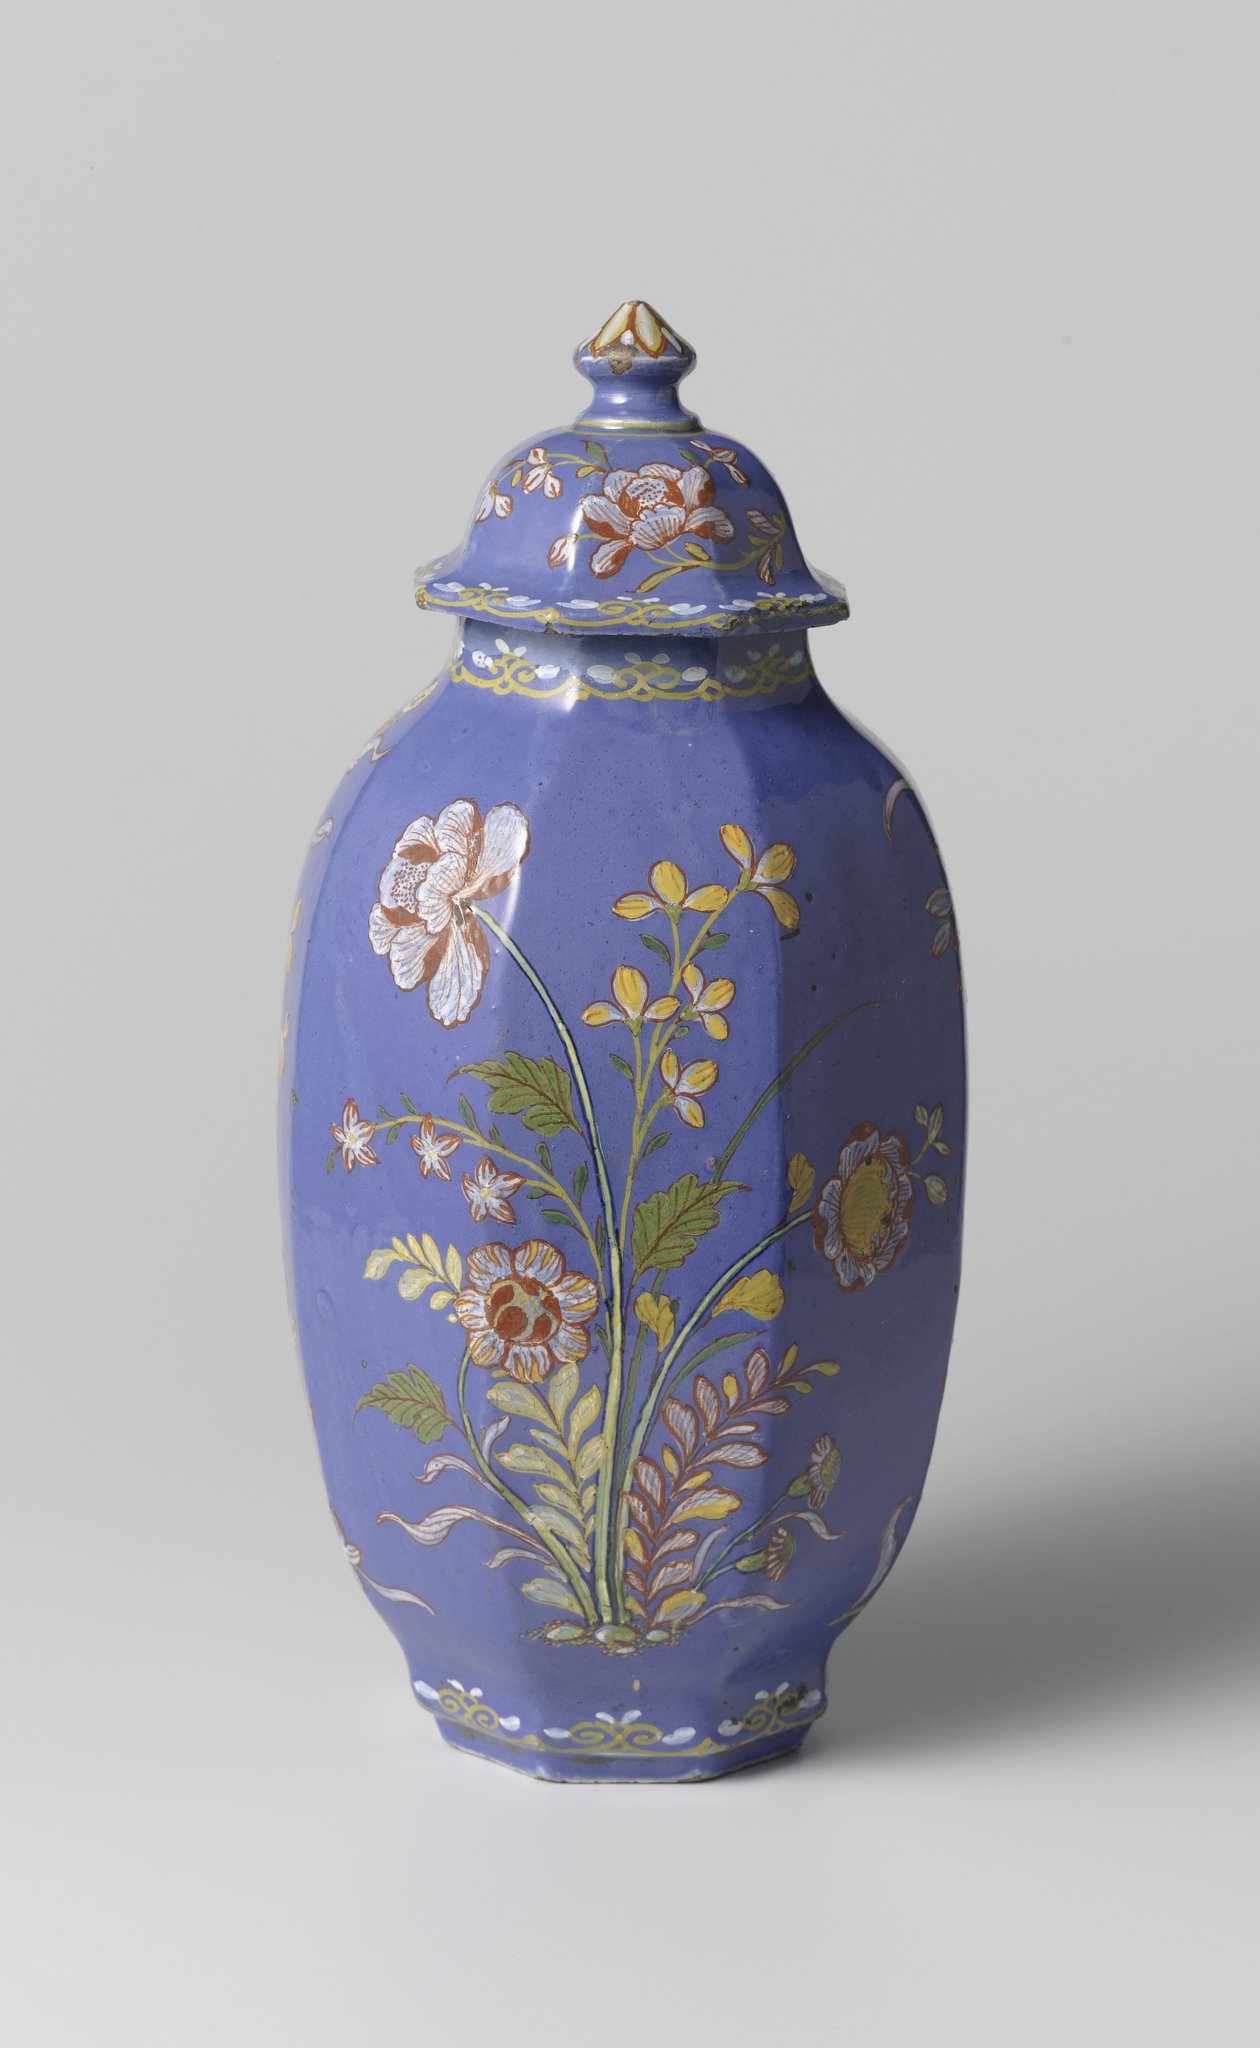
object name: covered jar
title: Pot met deksel van veelkleurig beschilderde faïence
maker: Anonymous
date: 1700-1735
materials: faience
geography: delft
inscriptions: label: ‘363’, mark: ‘D/ 12/ 8’, collector's mark: ‘collection JF Loudon’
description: Pot met deksel van faïence. Veelkleurig beschilderd met bloemen op een blauw fond.